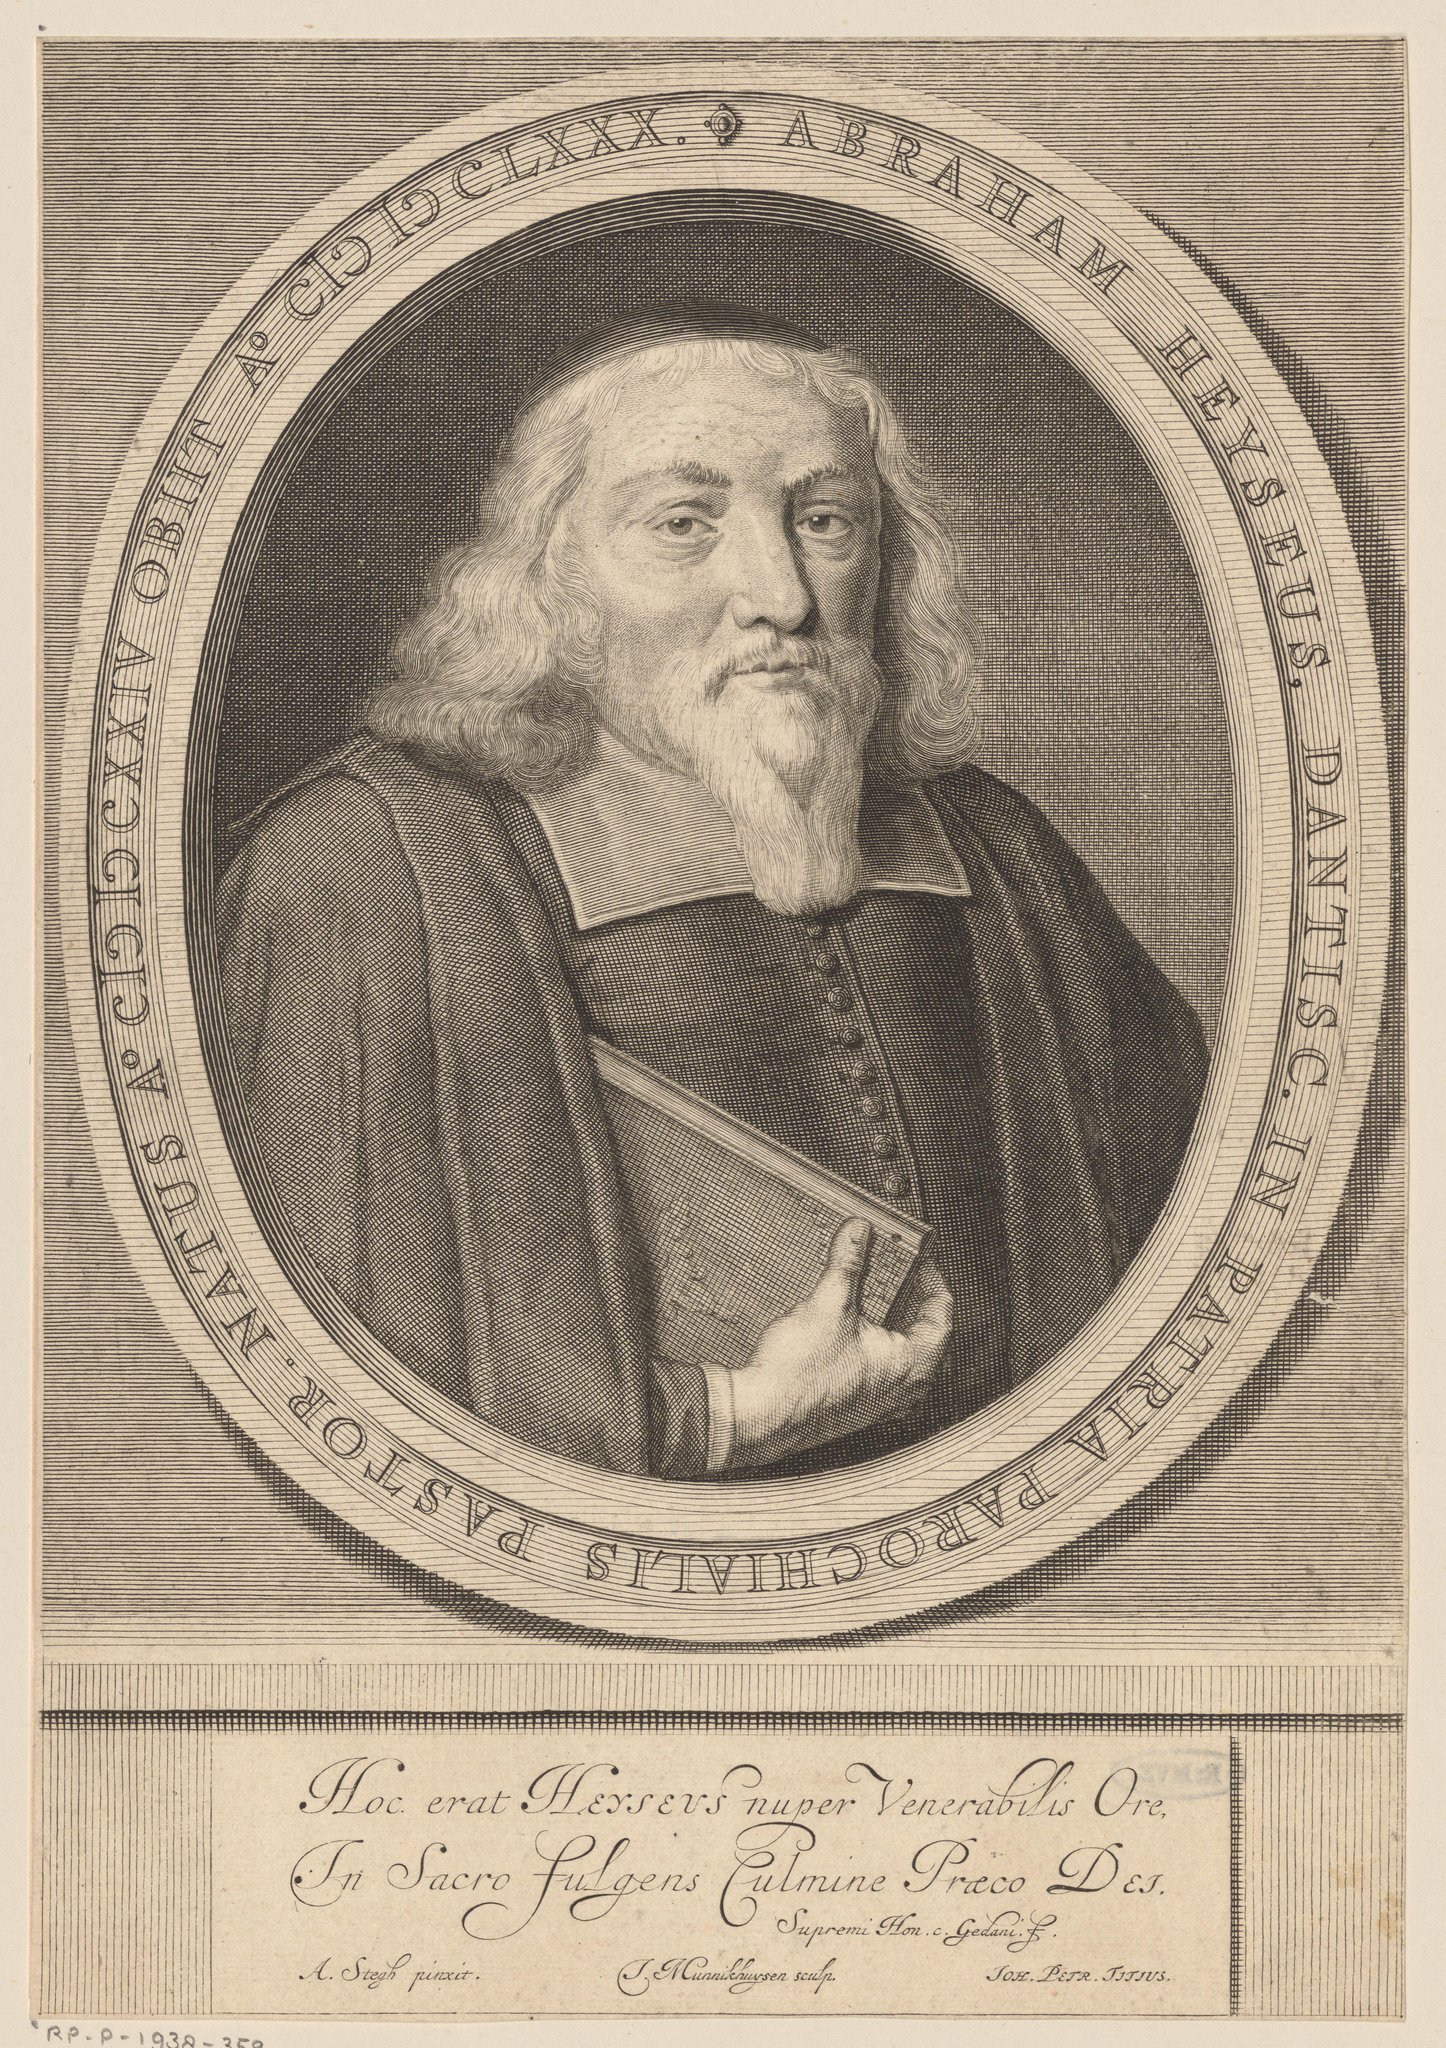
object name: print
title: Portret van Abraham Heyse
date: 1680-1701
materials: paper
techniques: engraving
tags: theologian, historical persons, book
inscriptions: collector's mark: Lugt 2228